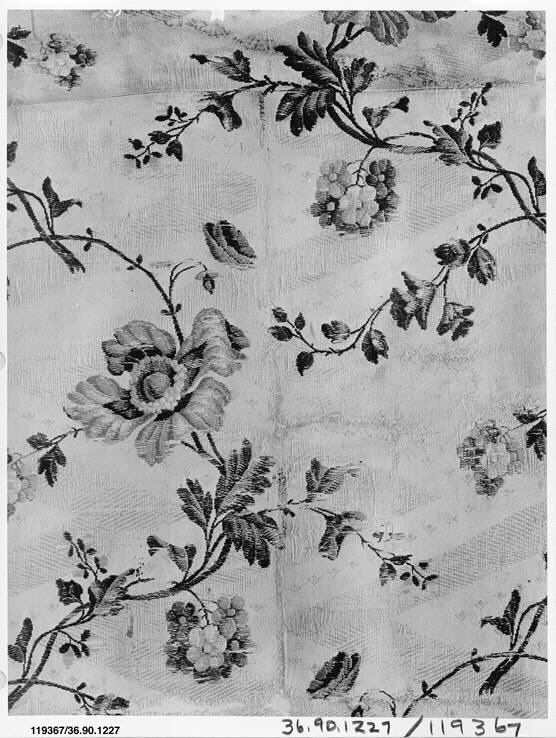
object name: piece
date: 1750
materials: silk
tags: flowers,leaves